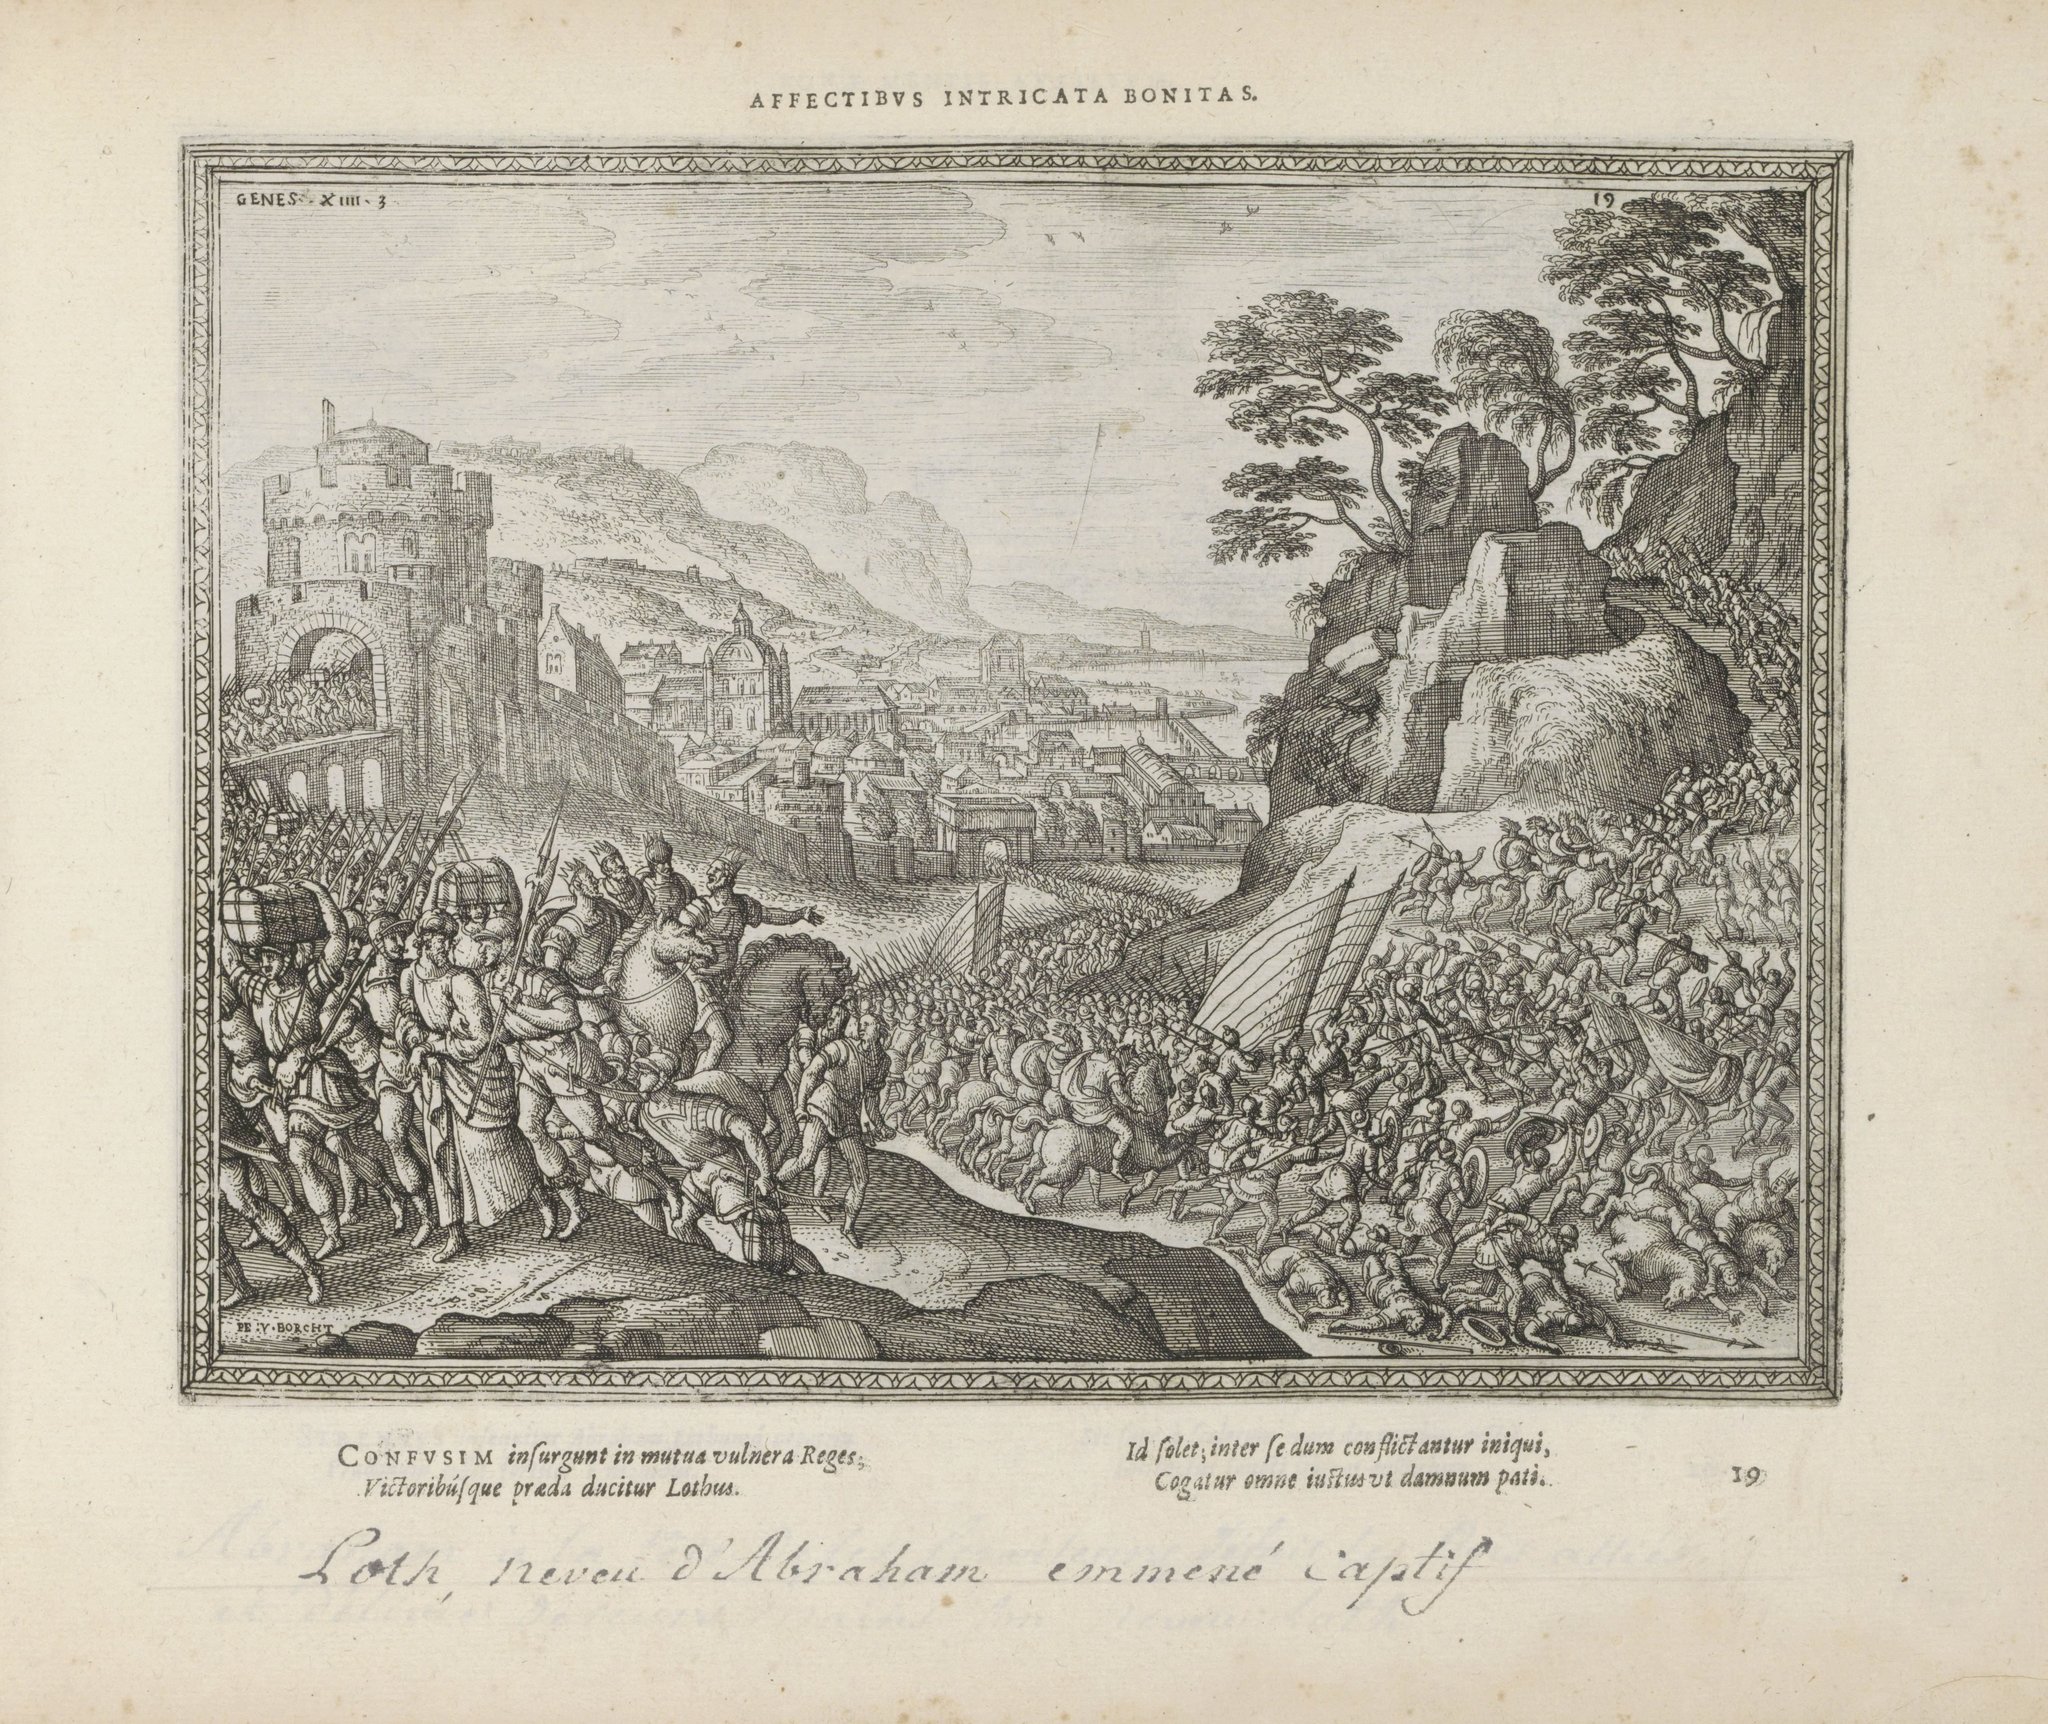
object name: print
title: Emblemata Sacra è praecipuis utriusque testamenti historiis concinnata (Oude Testament)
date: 1582-1593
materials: paper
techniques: etching, letterpress printing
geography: antwerp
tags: sodom and gomorrah are plundered; lot is taken into captivity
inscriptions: inscription: ‘Loth, neveu d'Abraham emmené captif’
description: Lot wordt bij de val van Sodom gevangengenomen en weggevoerd door de koningen van Sinear, Ellasar, Elam en Goïm (Gen. 14: 3). Met een motto in het Latijn boven de voorstelling en een vierregelig onderschrift in het Latijn onder de prent. De prent maakt deel uit van een album.